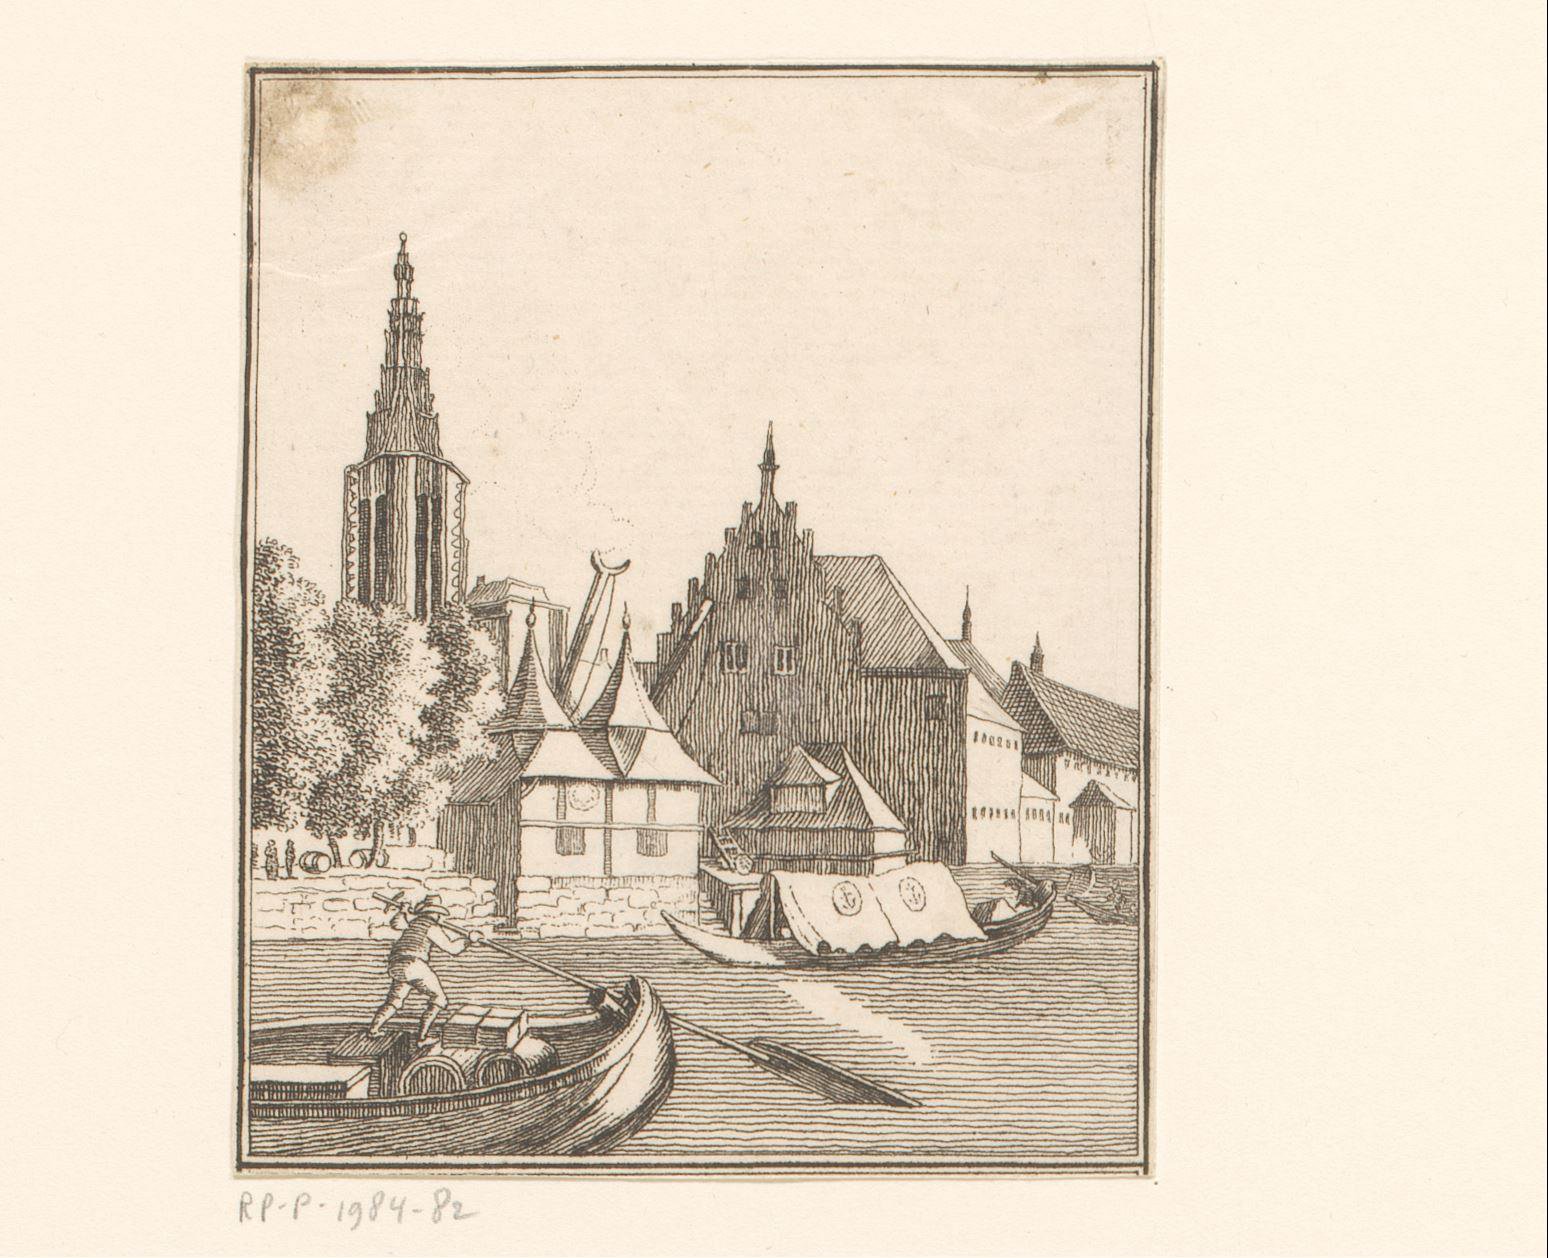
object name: print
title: Stadsgezicht met toren, mogelijk te Brugge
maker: jacob elias van varelen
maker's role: draughtsman, print maker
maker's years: 1757-1840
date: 1767-1840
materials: paper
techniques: etching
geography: haarlem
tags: tower, clock tower ~ monumental adornment, rowing-boat, canoe, etc., canals, waters (in city), bruges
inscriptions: collector's mark: Lugt 2228